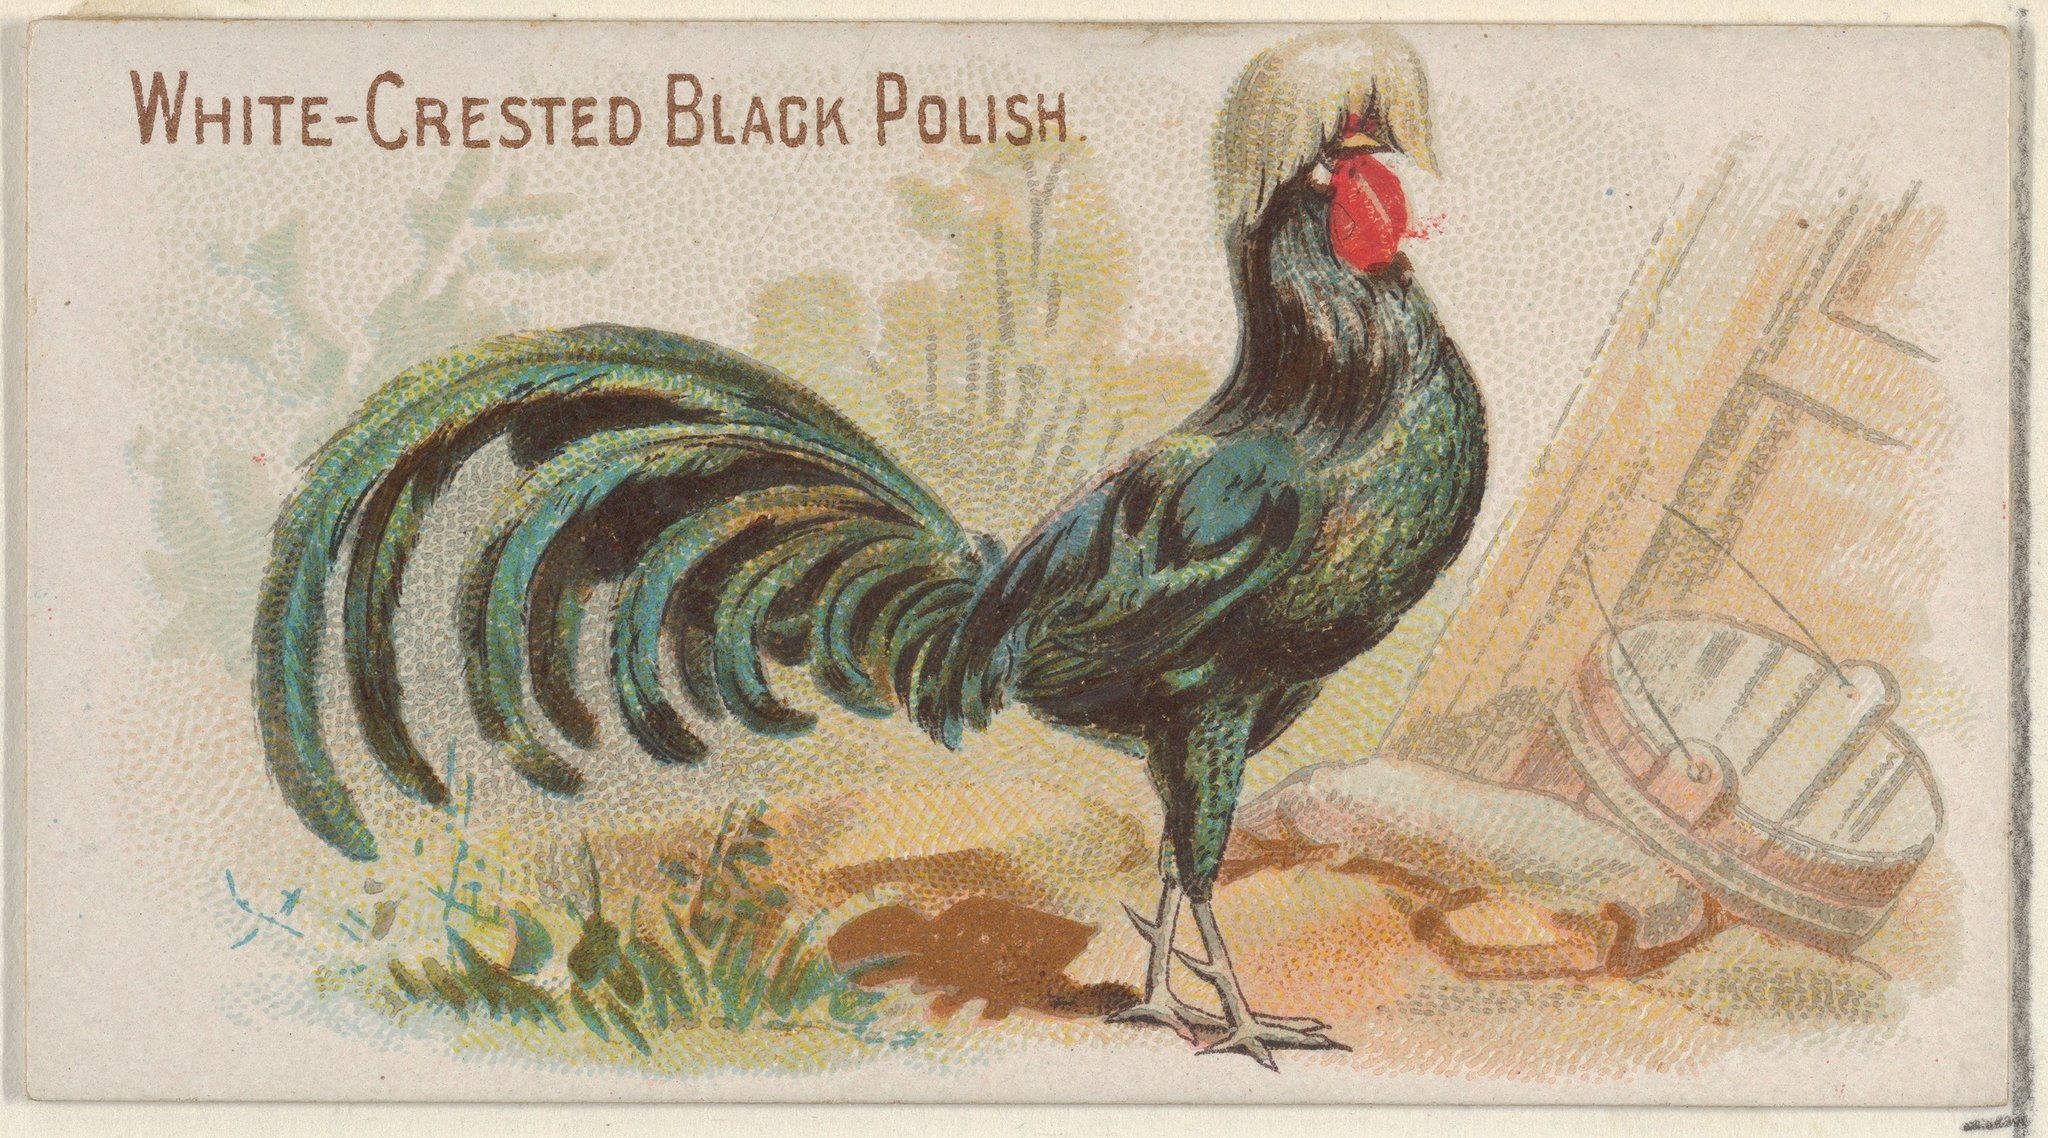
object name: print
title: White-Crested Black Polish, from the Prize and Game Chickens series (N20) for Allen & Ginter Cigarettes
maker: allen & ginter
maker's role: publisher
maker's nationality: american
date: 1891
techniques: color lithograph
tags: roosters